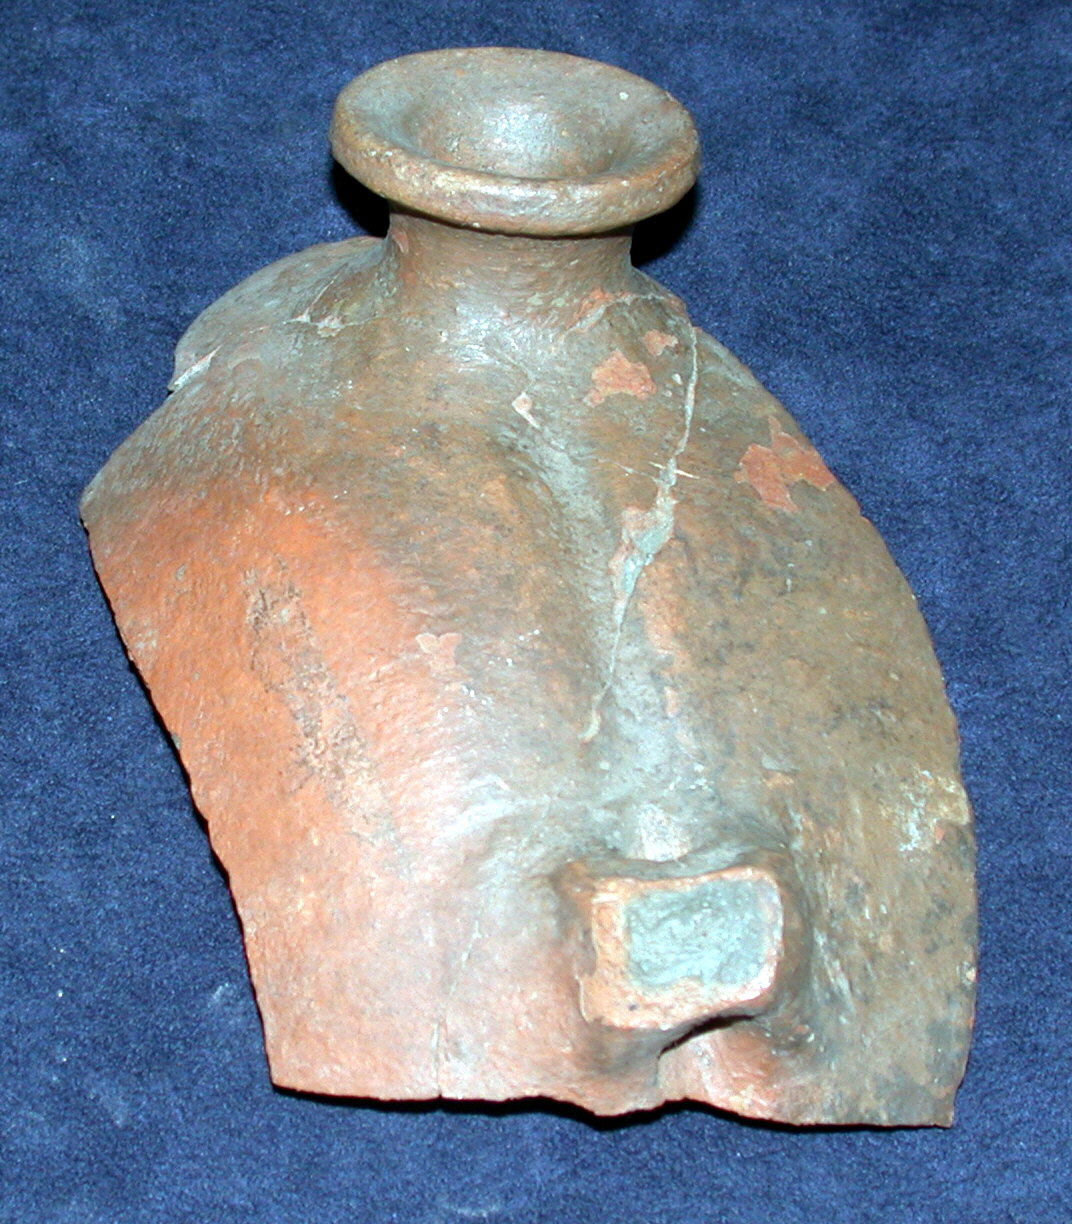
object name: flask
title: Pilgrim flask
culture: parthian or seleucid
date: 201-300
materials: ceramic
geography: iran